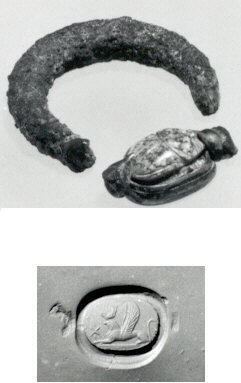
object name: ring with scarab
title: Silver ring with plasma scarab in a gold setting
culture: cypriot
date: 700-468 BCE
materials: gold, silver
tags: scarabs